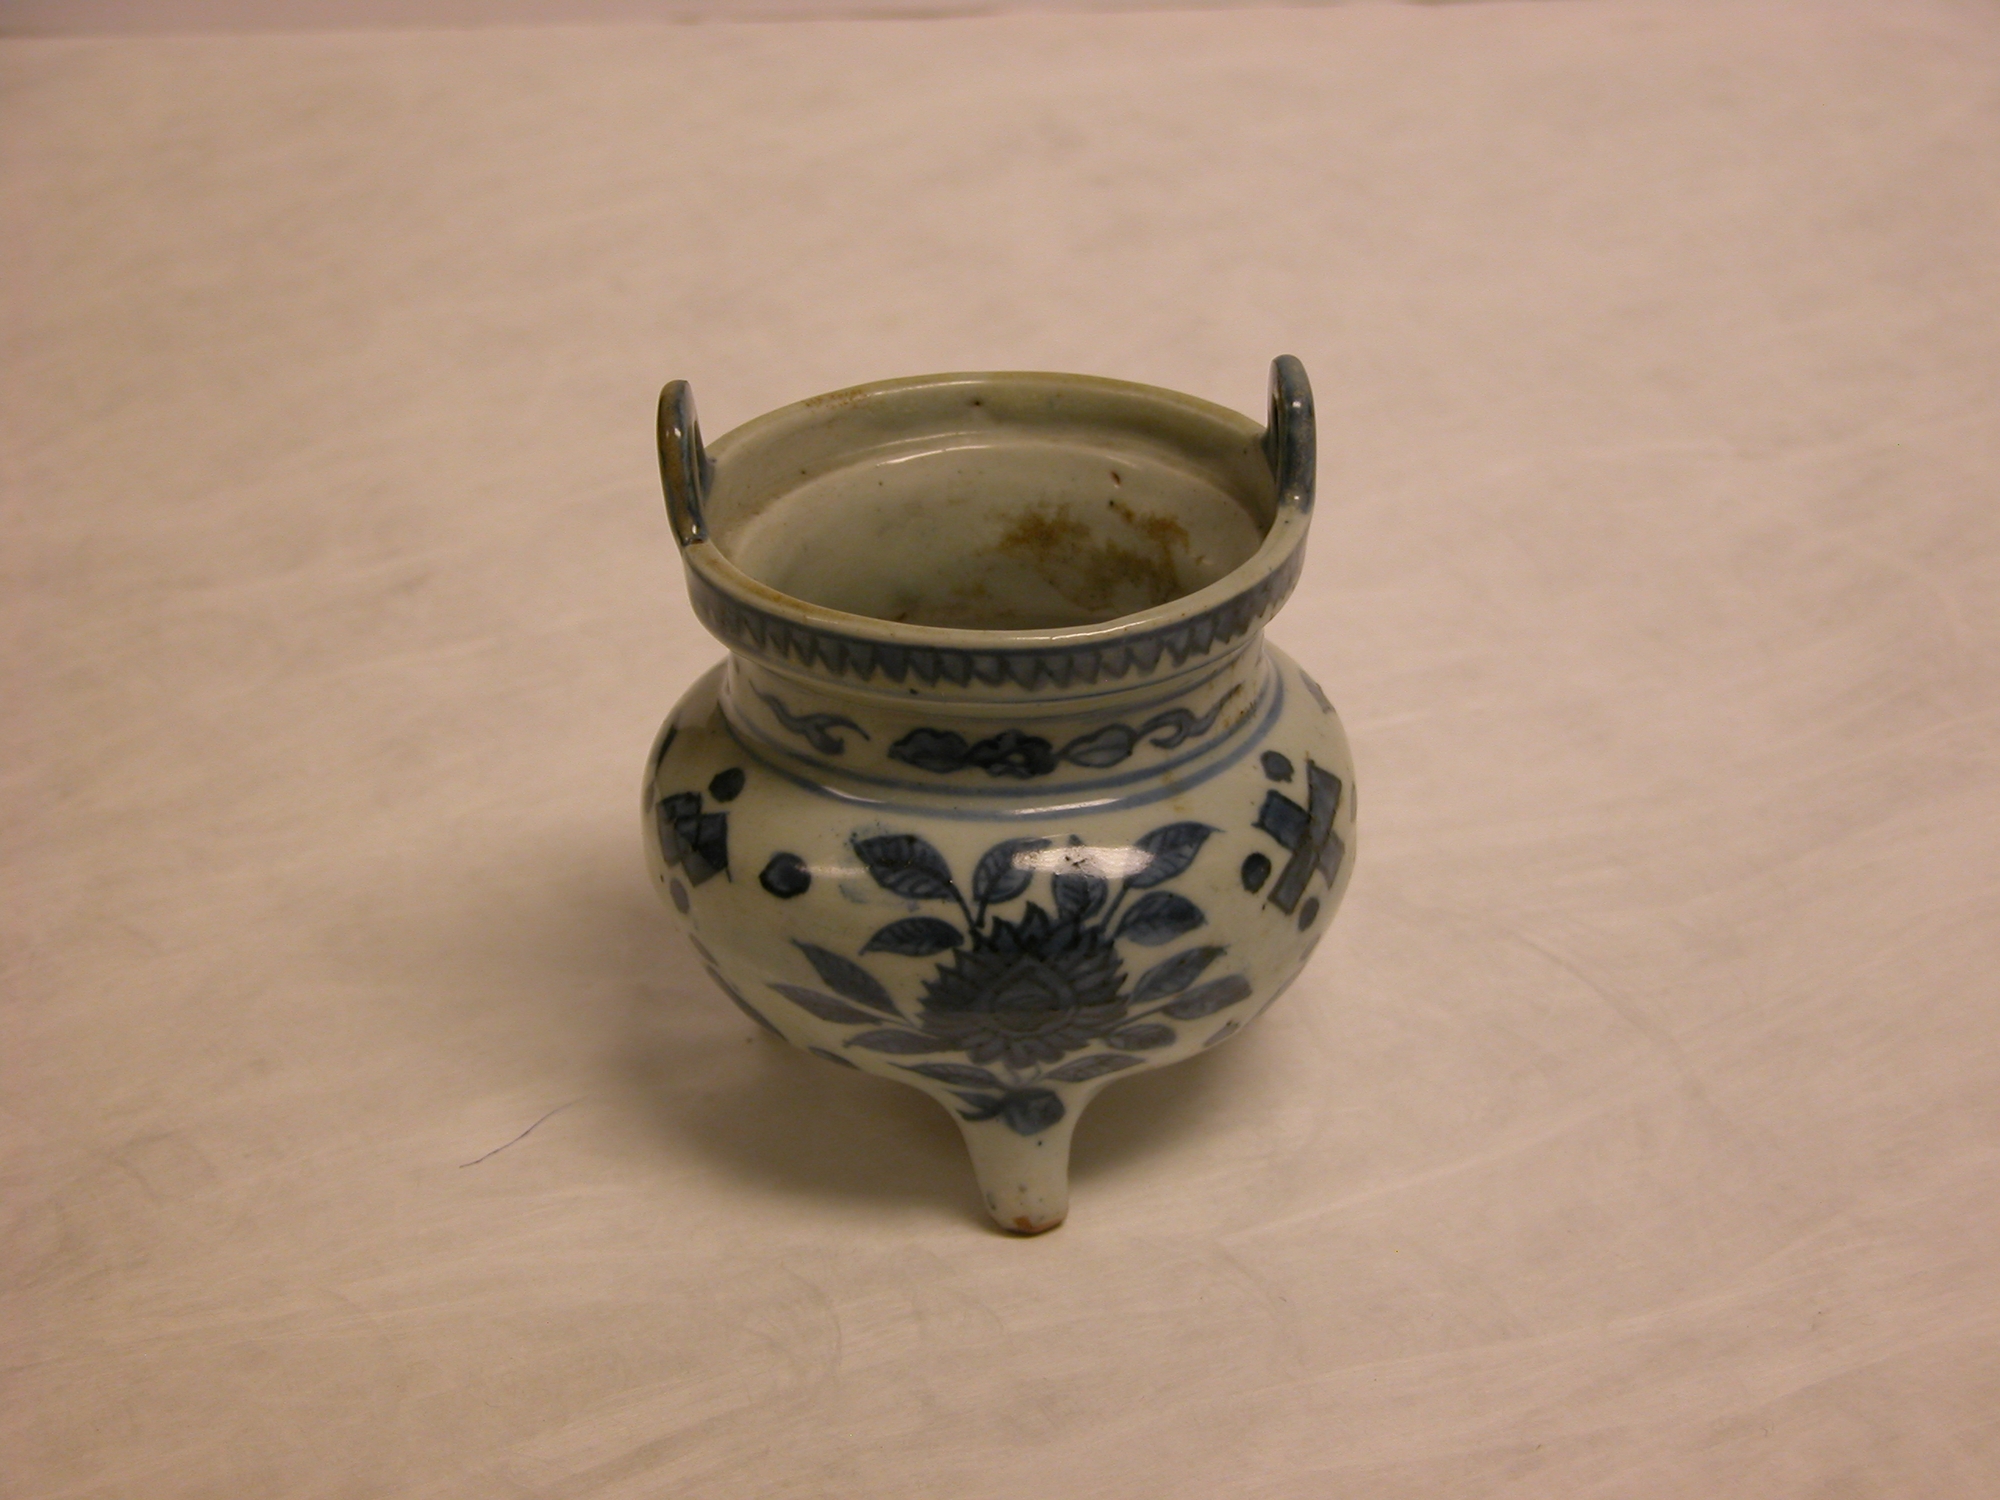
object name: incense burner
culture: chinese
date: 1368-1644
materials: porcelain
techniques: painting, underglaze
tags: flowers